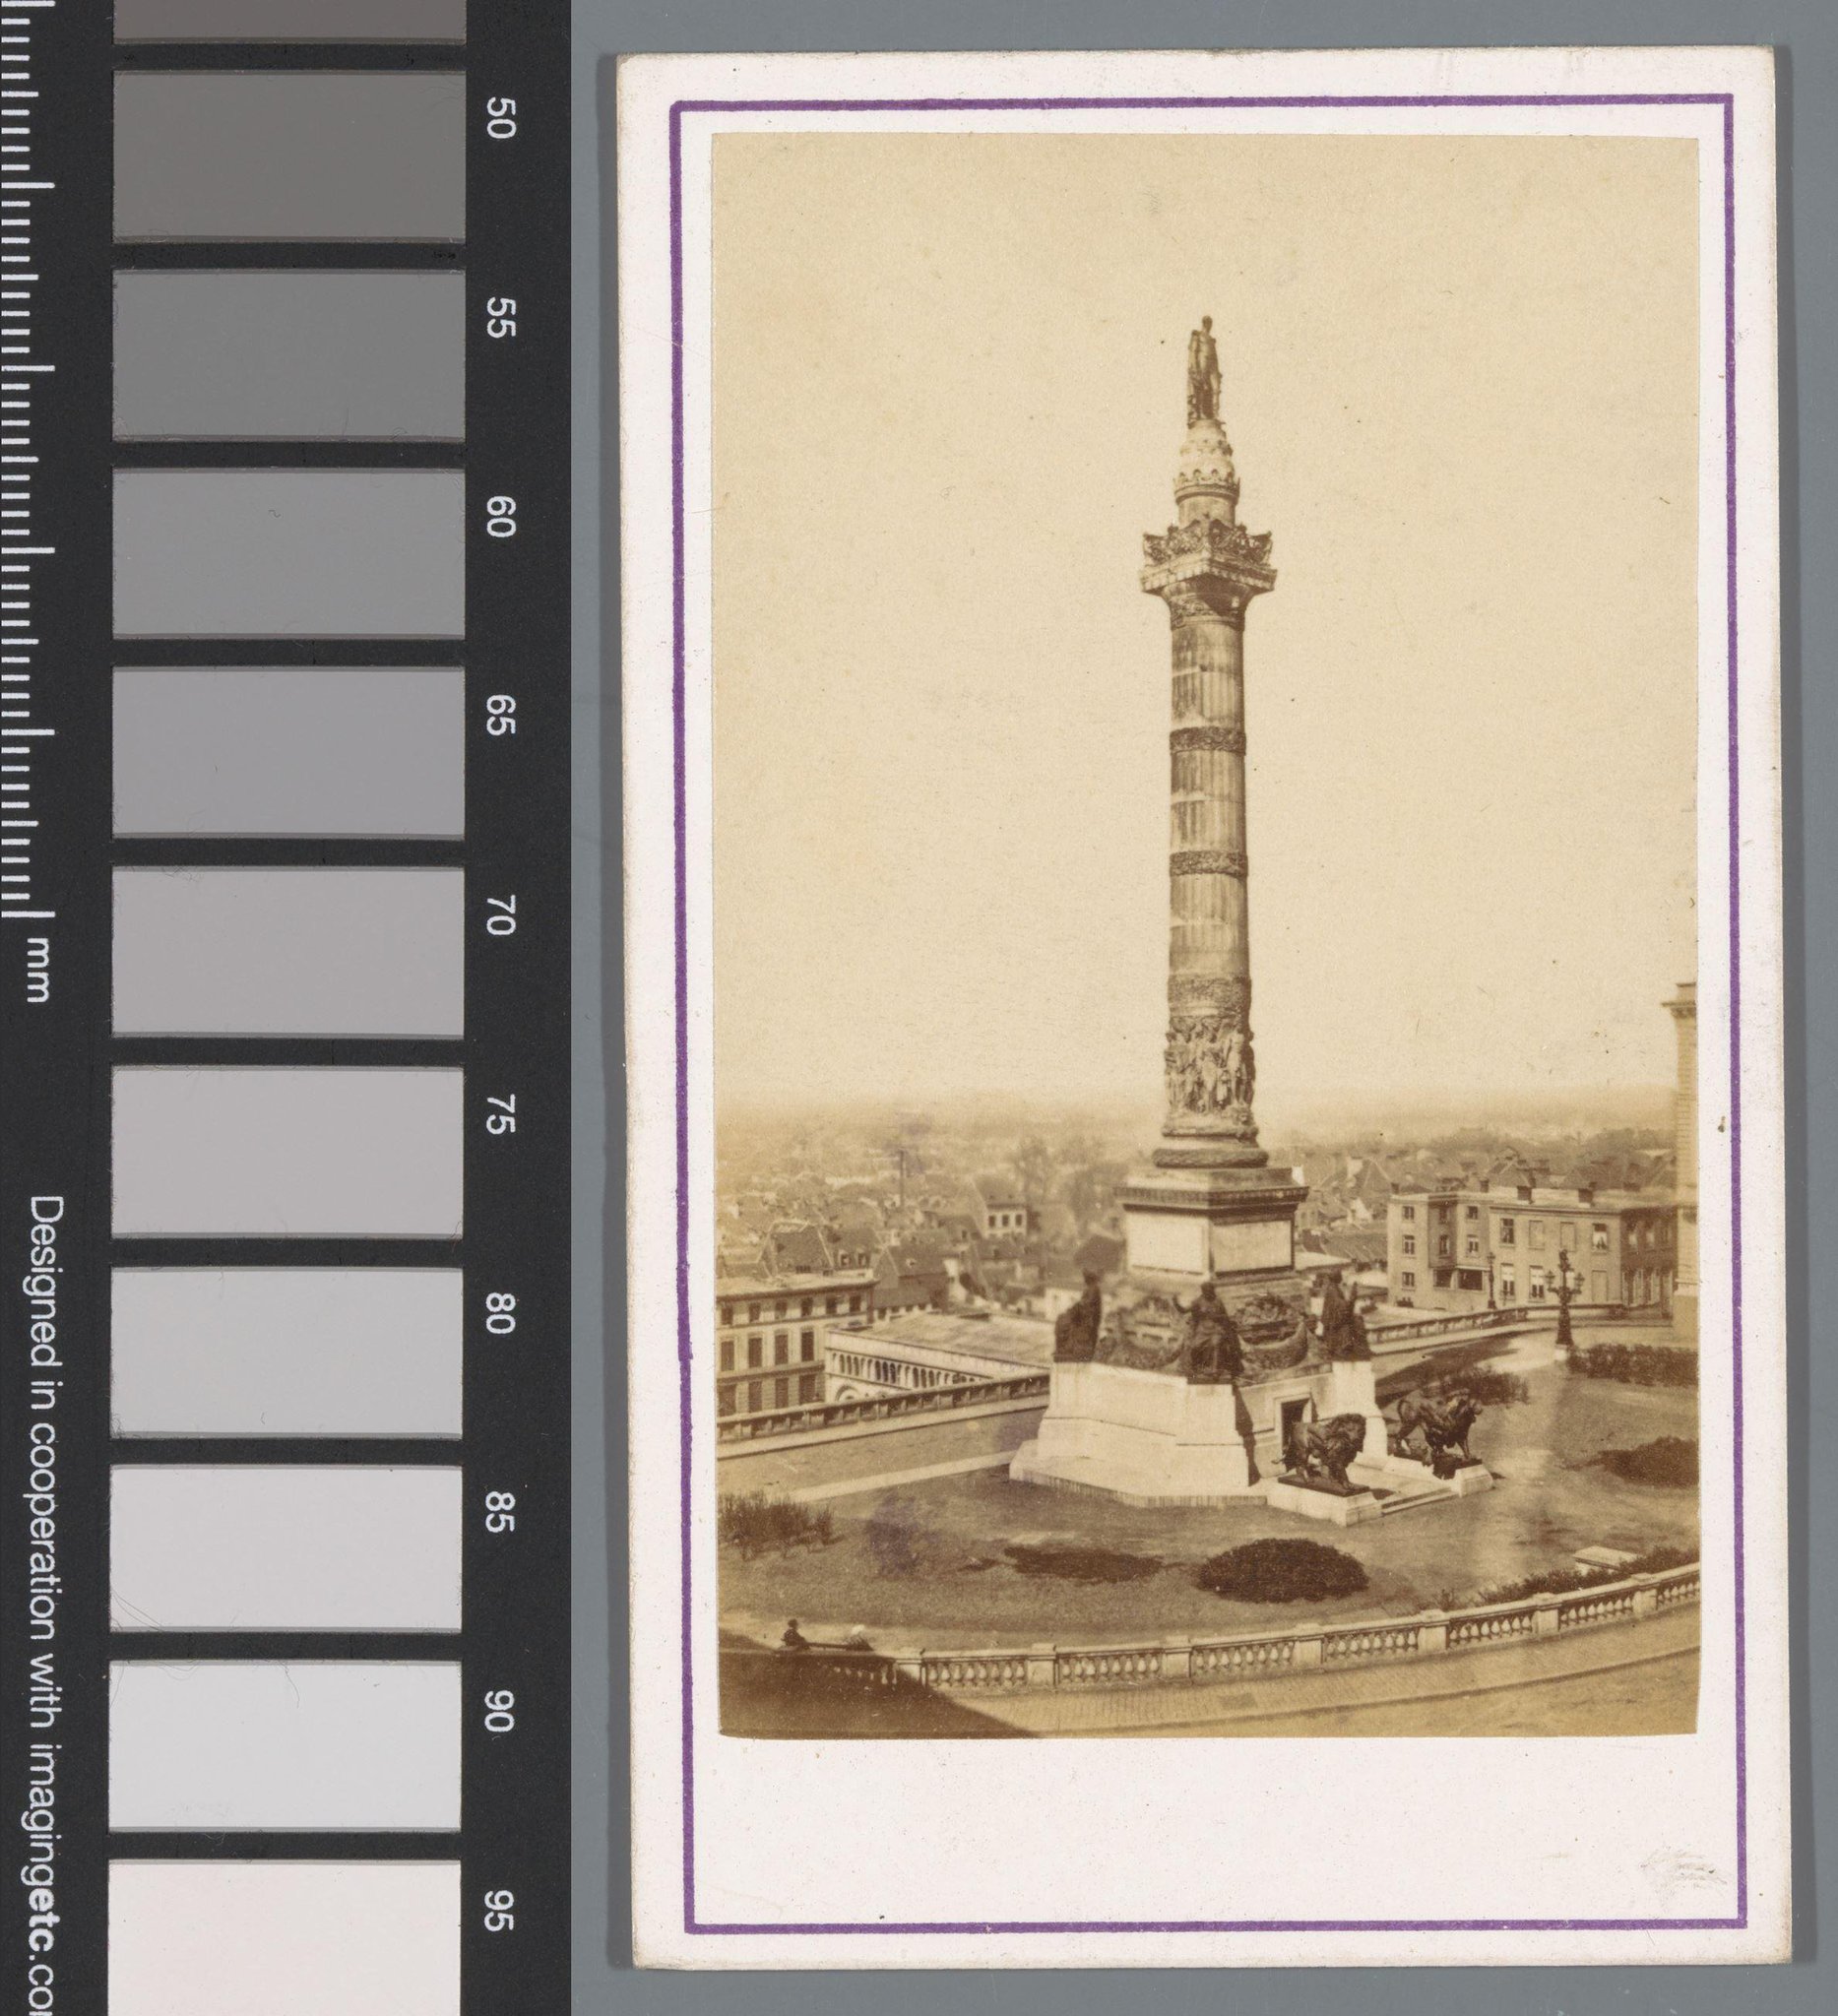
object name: carte de visite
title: Congreskolom in Brussel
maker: lyon cerf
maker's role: fotograaf, opticien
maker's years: 1837-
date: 1869-1885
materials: cardboard, paper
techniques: albumen print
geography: brussels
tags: triumphal column with helical friezes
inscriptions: inscription: ‘L. Cerf/ 20 Galerie du Roi, 20./ Bruxelles’